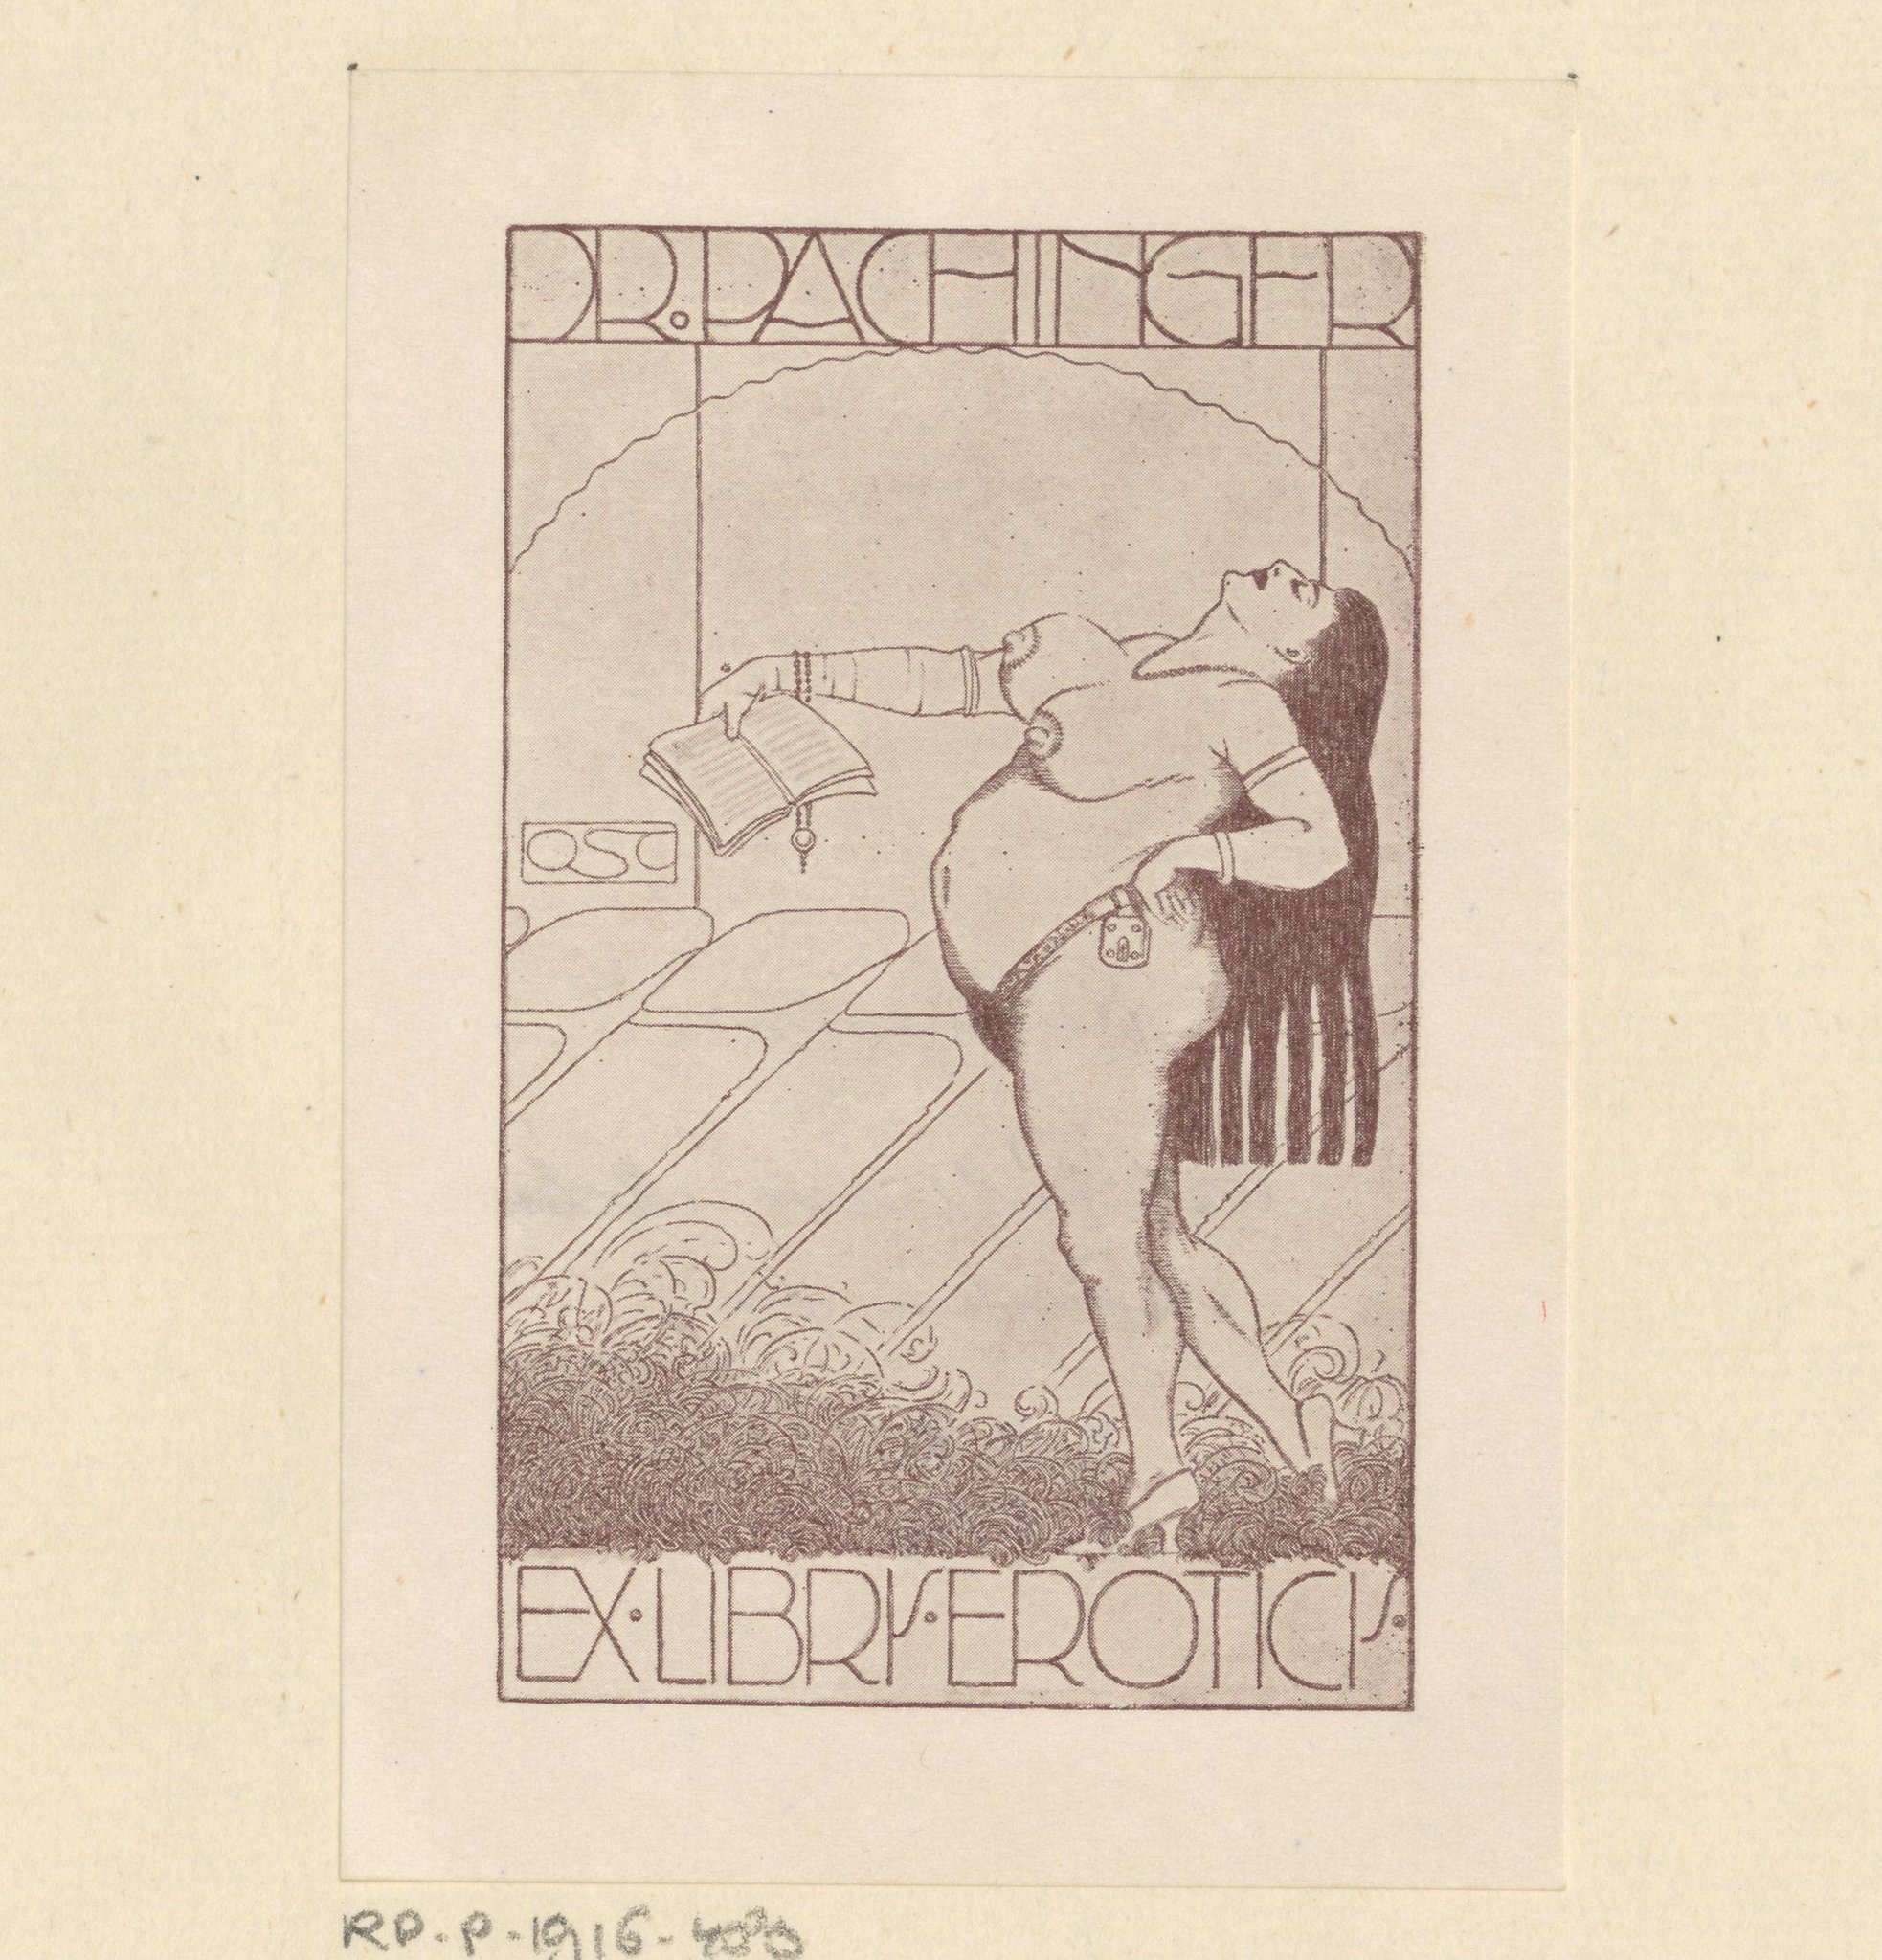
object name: bookplate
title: Dr. Pachinger ex libris eroticis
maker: Anonymous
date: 1874-1916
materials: paper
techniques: autotype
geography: munich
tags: vienna, woman (showing herself) undressed, quasi-nude, book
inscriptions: collector's mark: Lugt 2233, inscription: ‘"Volüptos."/ Ost Petersen [...]/ München fecit’